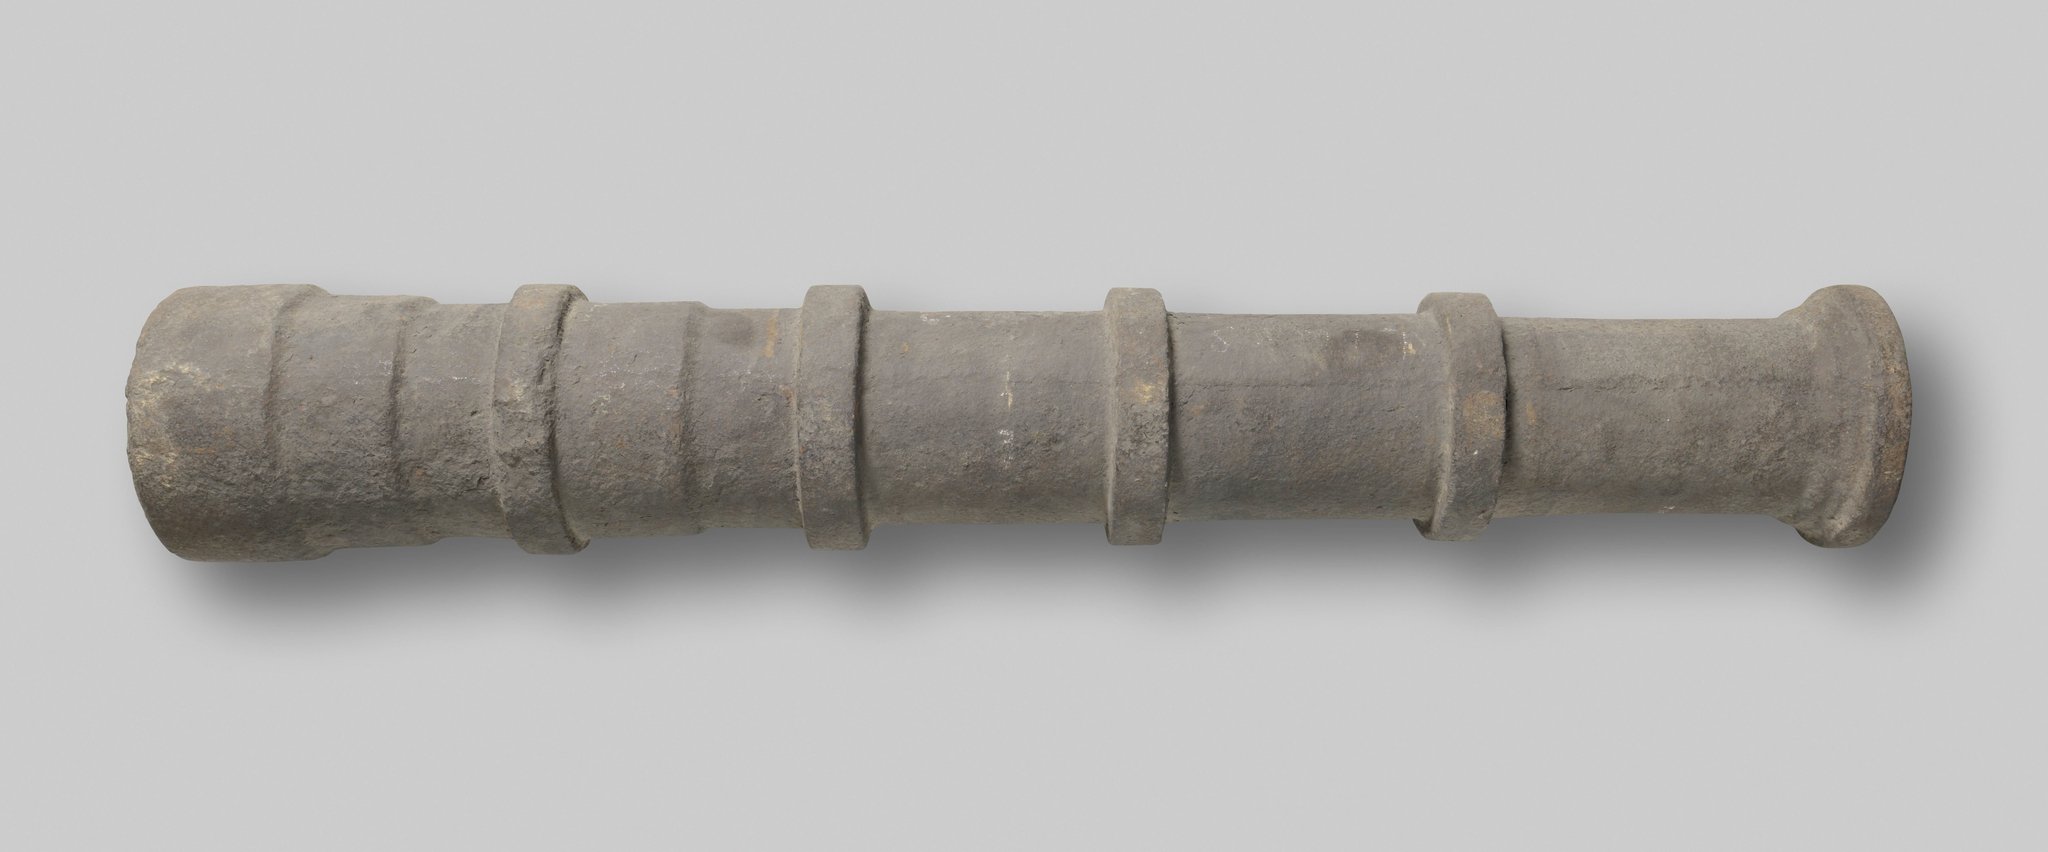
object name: cannon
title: Gietijzeren achterlader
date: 1500-1550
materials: iron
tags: groningen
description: Gietijzeren kamerstuk met vier ringvormige verdikkingen. De kamer en de houten lade waarin het kanon oorspronkelijk heeft gelegen, zijn niet bewaard gebleven. Achterlader. Het kanon is aangetroffen bij het afbreken van de zuidelijke vestingmuur van Groningen in 1880.